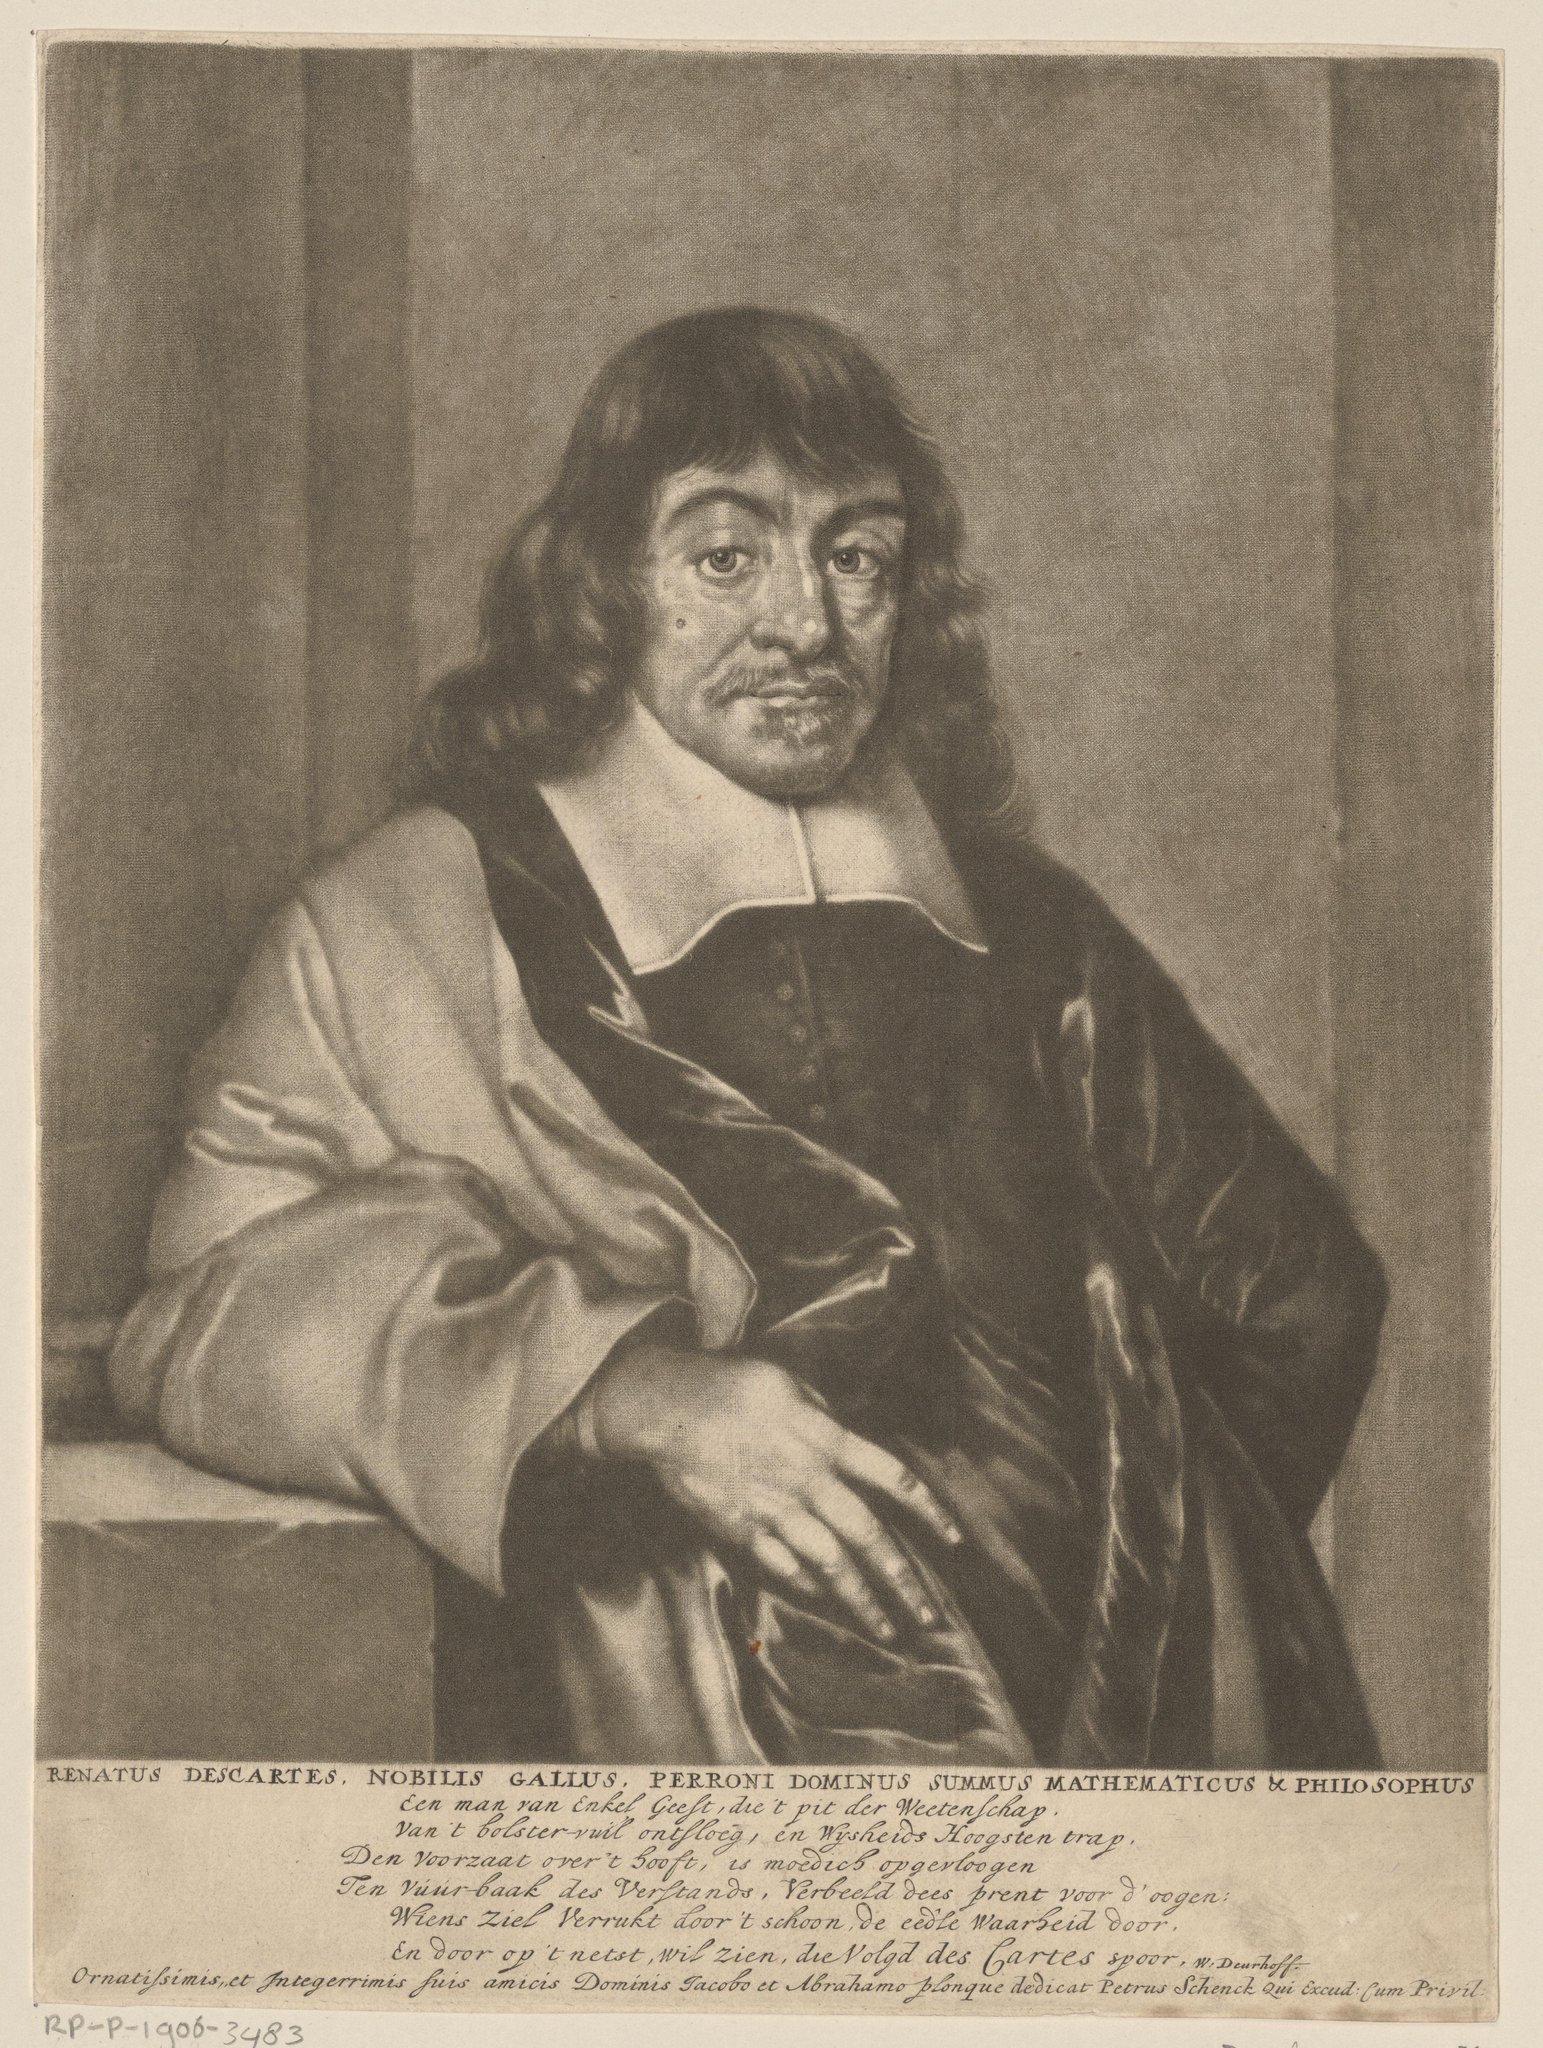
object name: print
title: Portret van René Descartes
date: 1670-1713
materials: paper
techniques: engraving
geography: amsterdam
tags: rené descartes, scholar, philosopher, historical persons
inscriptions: collector's mark: Lugt 2228